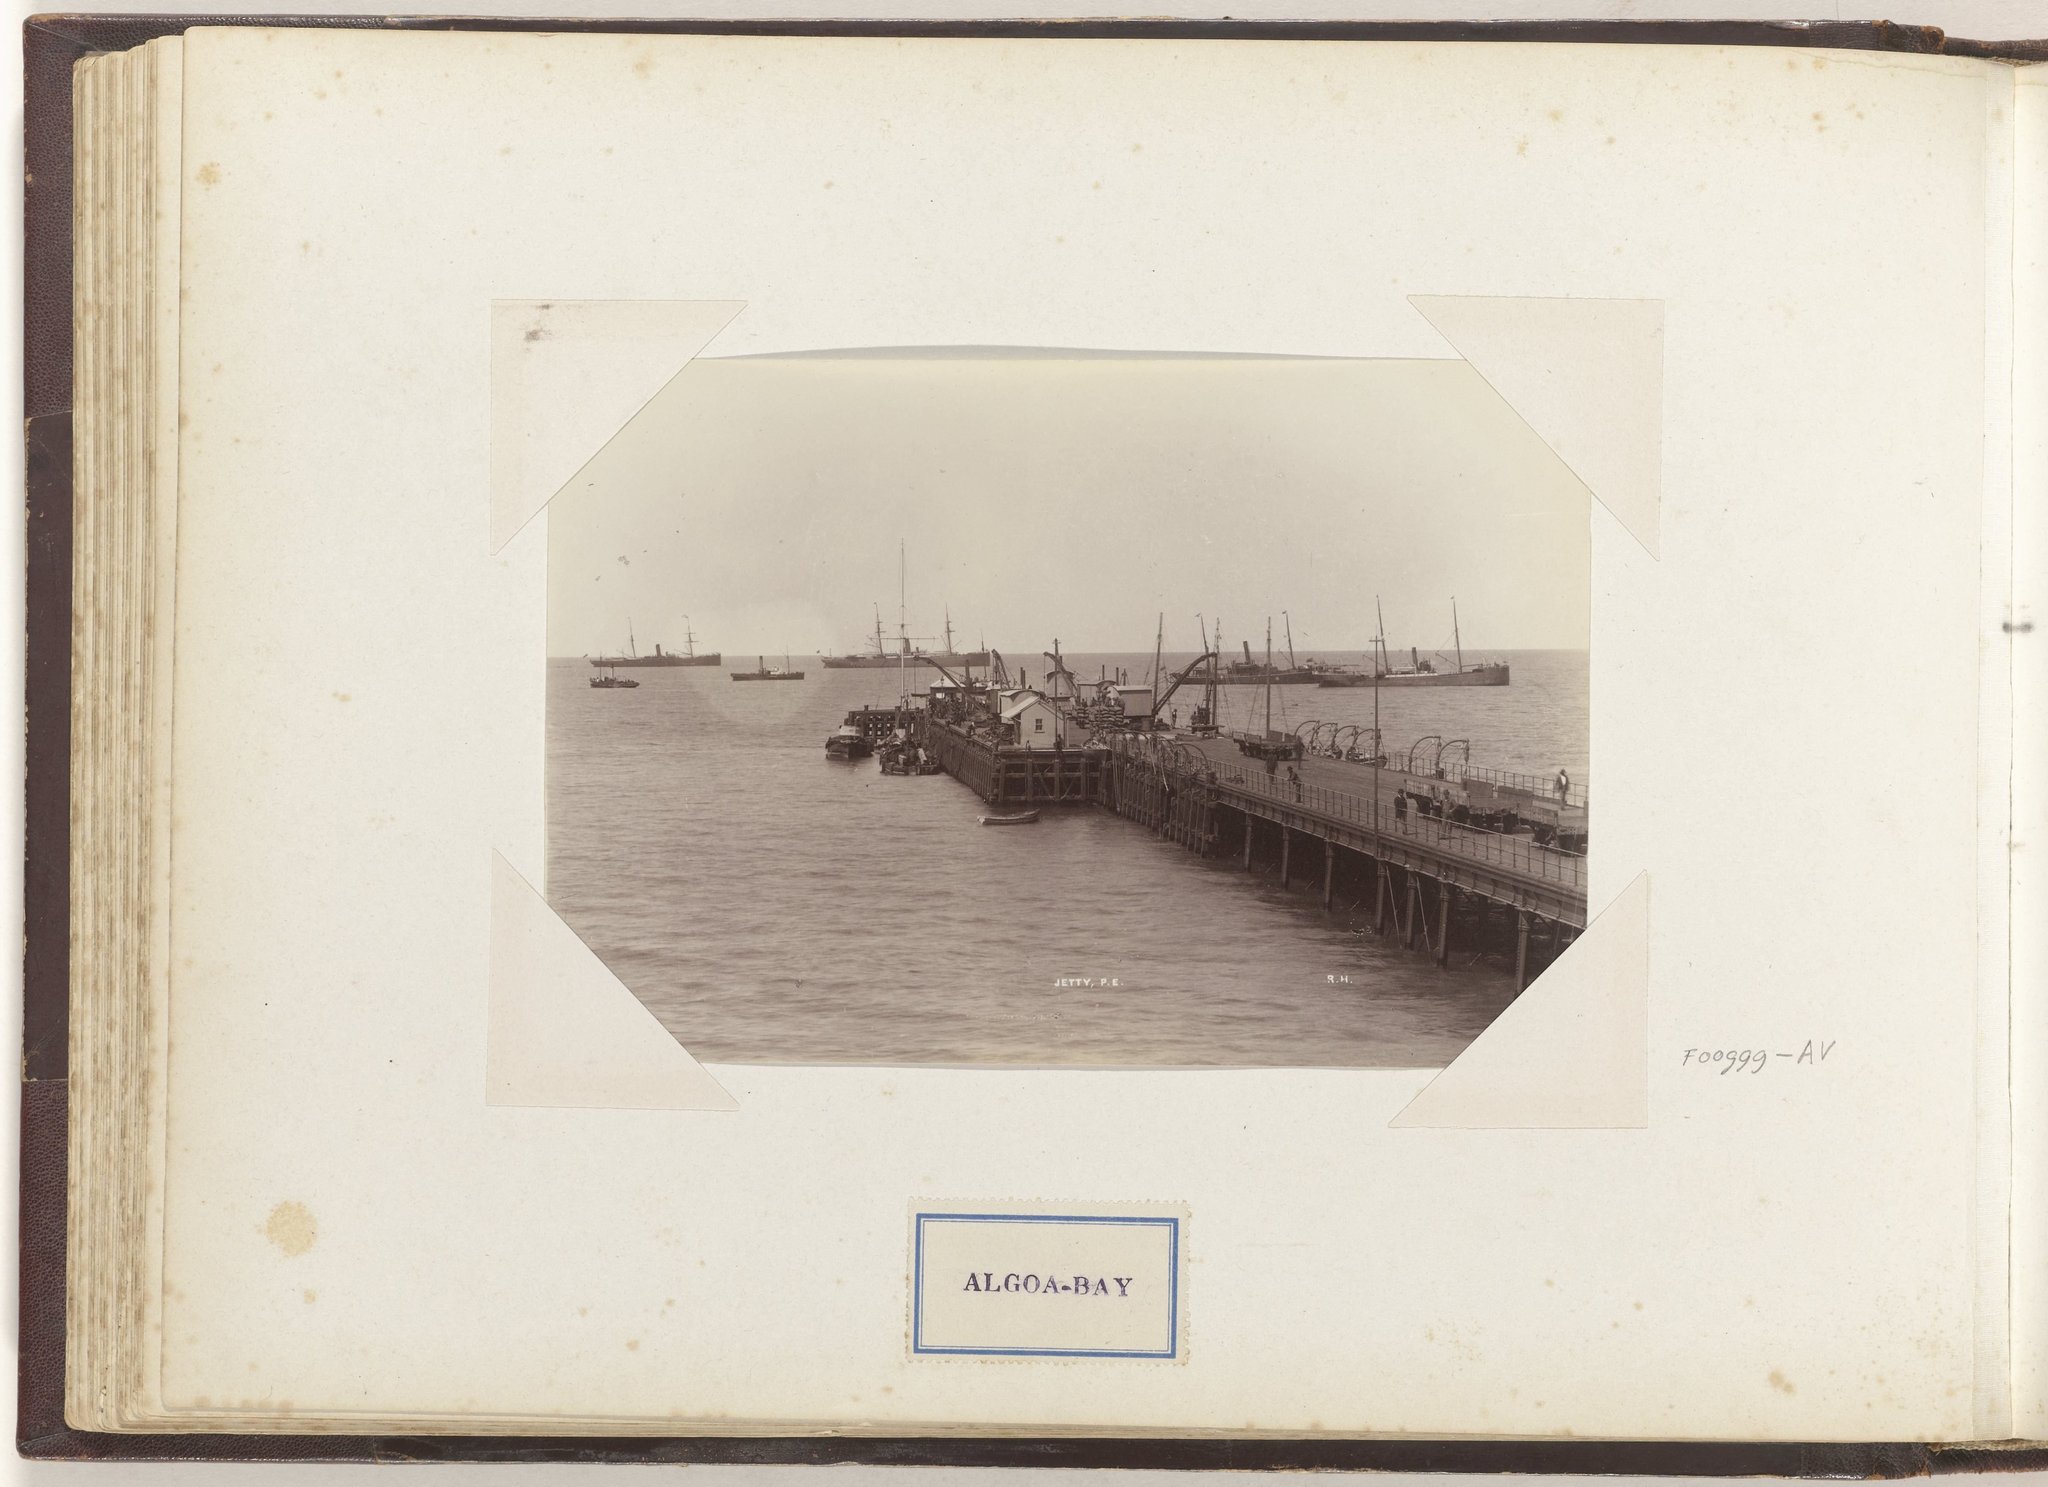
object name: photograph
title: Steiger in de haven van Port Elizabeth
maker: rh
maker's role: fotograaf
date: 1885-1910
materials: paper, photographic support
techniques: albumen print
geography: port elizabeth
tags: harbour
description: Onderdeel van Album met 191 foto's van een reis naar en door Zuid-Afrika.